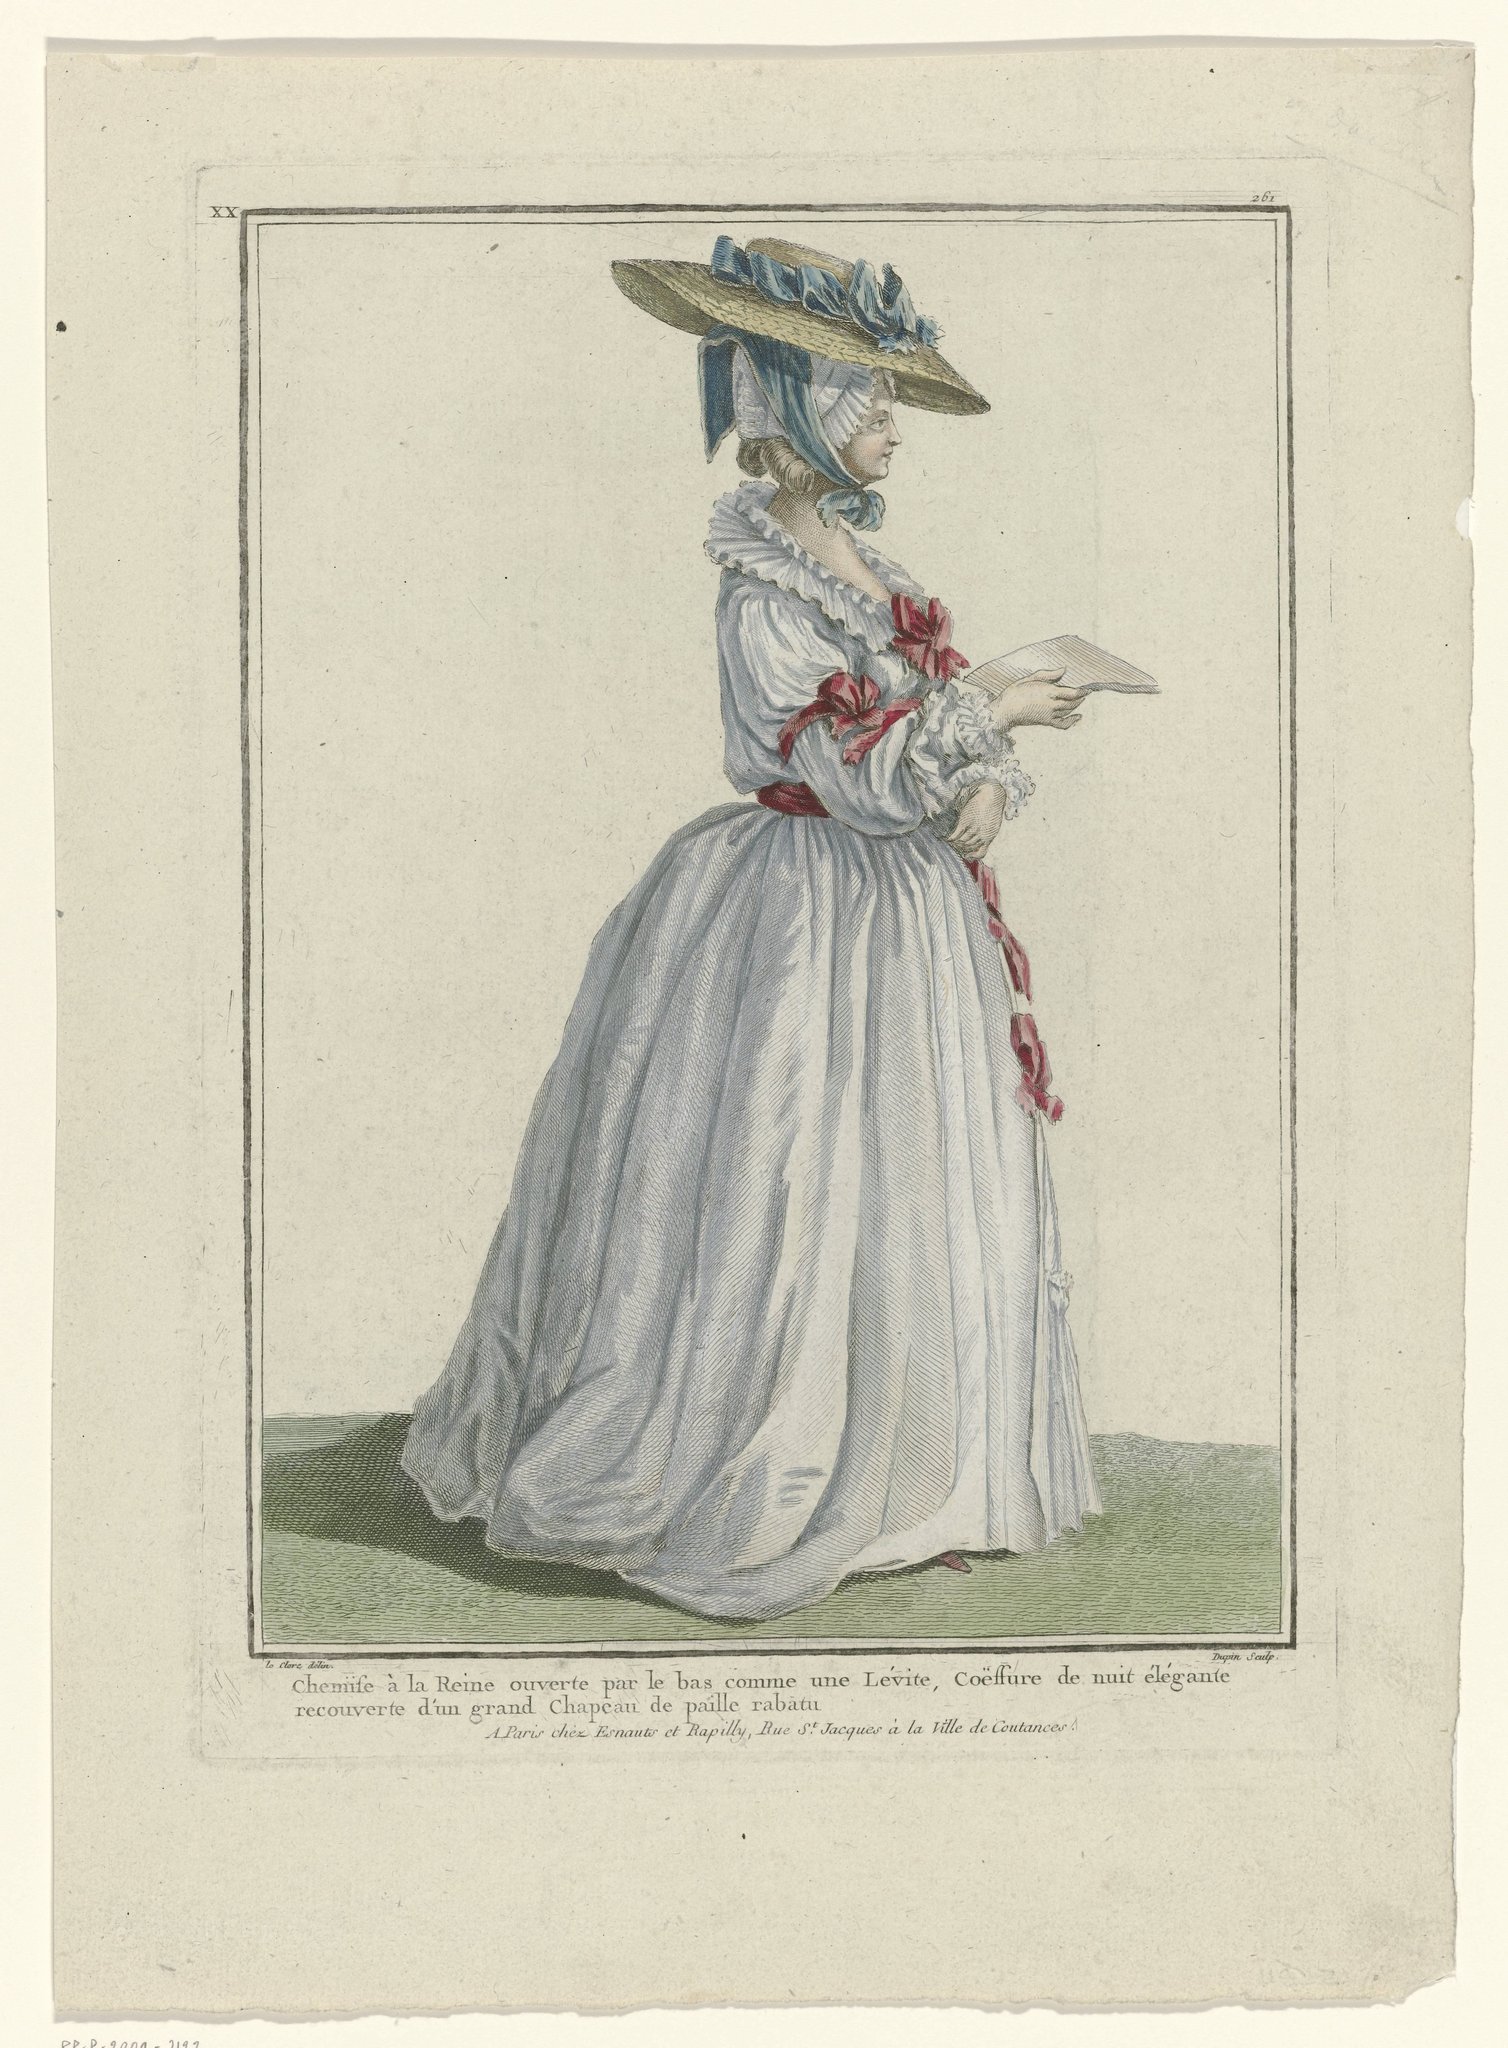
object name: fashion print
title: Marie Antoinette: The Queen of Fashion: Gallerie des Modes et Costumes Français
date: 1784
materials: paper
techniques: engraving, hand coloring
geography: paris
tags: bow (ornamental part of clothing) (+ women's clothes), dress, gown: chemise à la reine (+ women's clothes), head-gear (straw hat) (+ women's clothes), head-gear: cap (+ women's clothes), neck-gear: collar (+ women's clothes), fashion plates, letter, envelope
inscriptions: caption: ‘Chemise à la Reine ouverte par le bas comme une Lévite, Coëffure de nuit élégante recouverte d'un grand Chapeau de paille rabatu.’, address: ‘A Paris chez Esnauts et Rapilly, Rue St. Jacques, à la Ville de Coutances.’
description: French queens were expected to set an example in the realm of fashion. As the wife of Louis XVI, Marie Antoinette threw herself into this task with enthusiasm. Together with her marchande de modes Rose Bertin and her hairdresser Léonard, she launched many a new fashion. Court etiquette dictated robes de cour – lavishly embellished gowns with wide skirts. When receiving visitors, Marie Antoinette wore a robe à la polonaise 1 2, but preferred an informal, loose-fitting gown when at her own pavilion in Versailles. This chemise de la reine 3 was quickly adopted by other women of the elite.